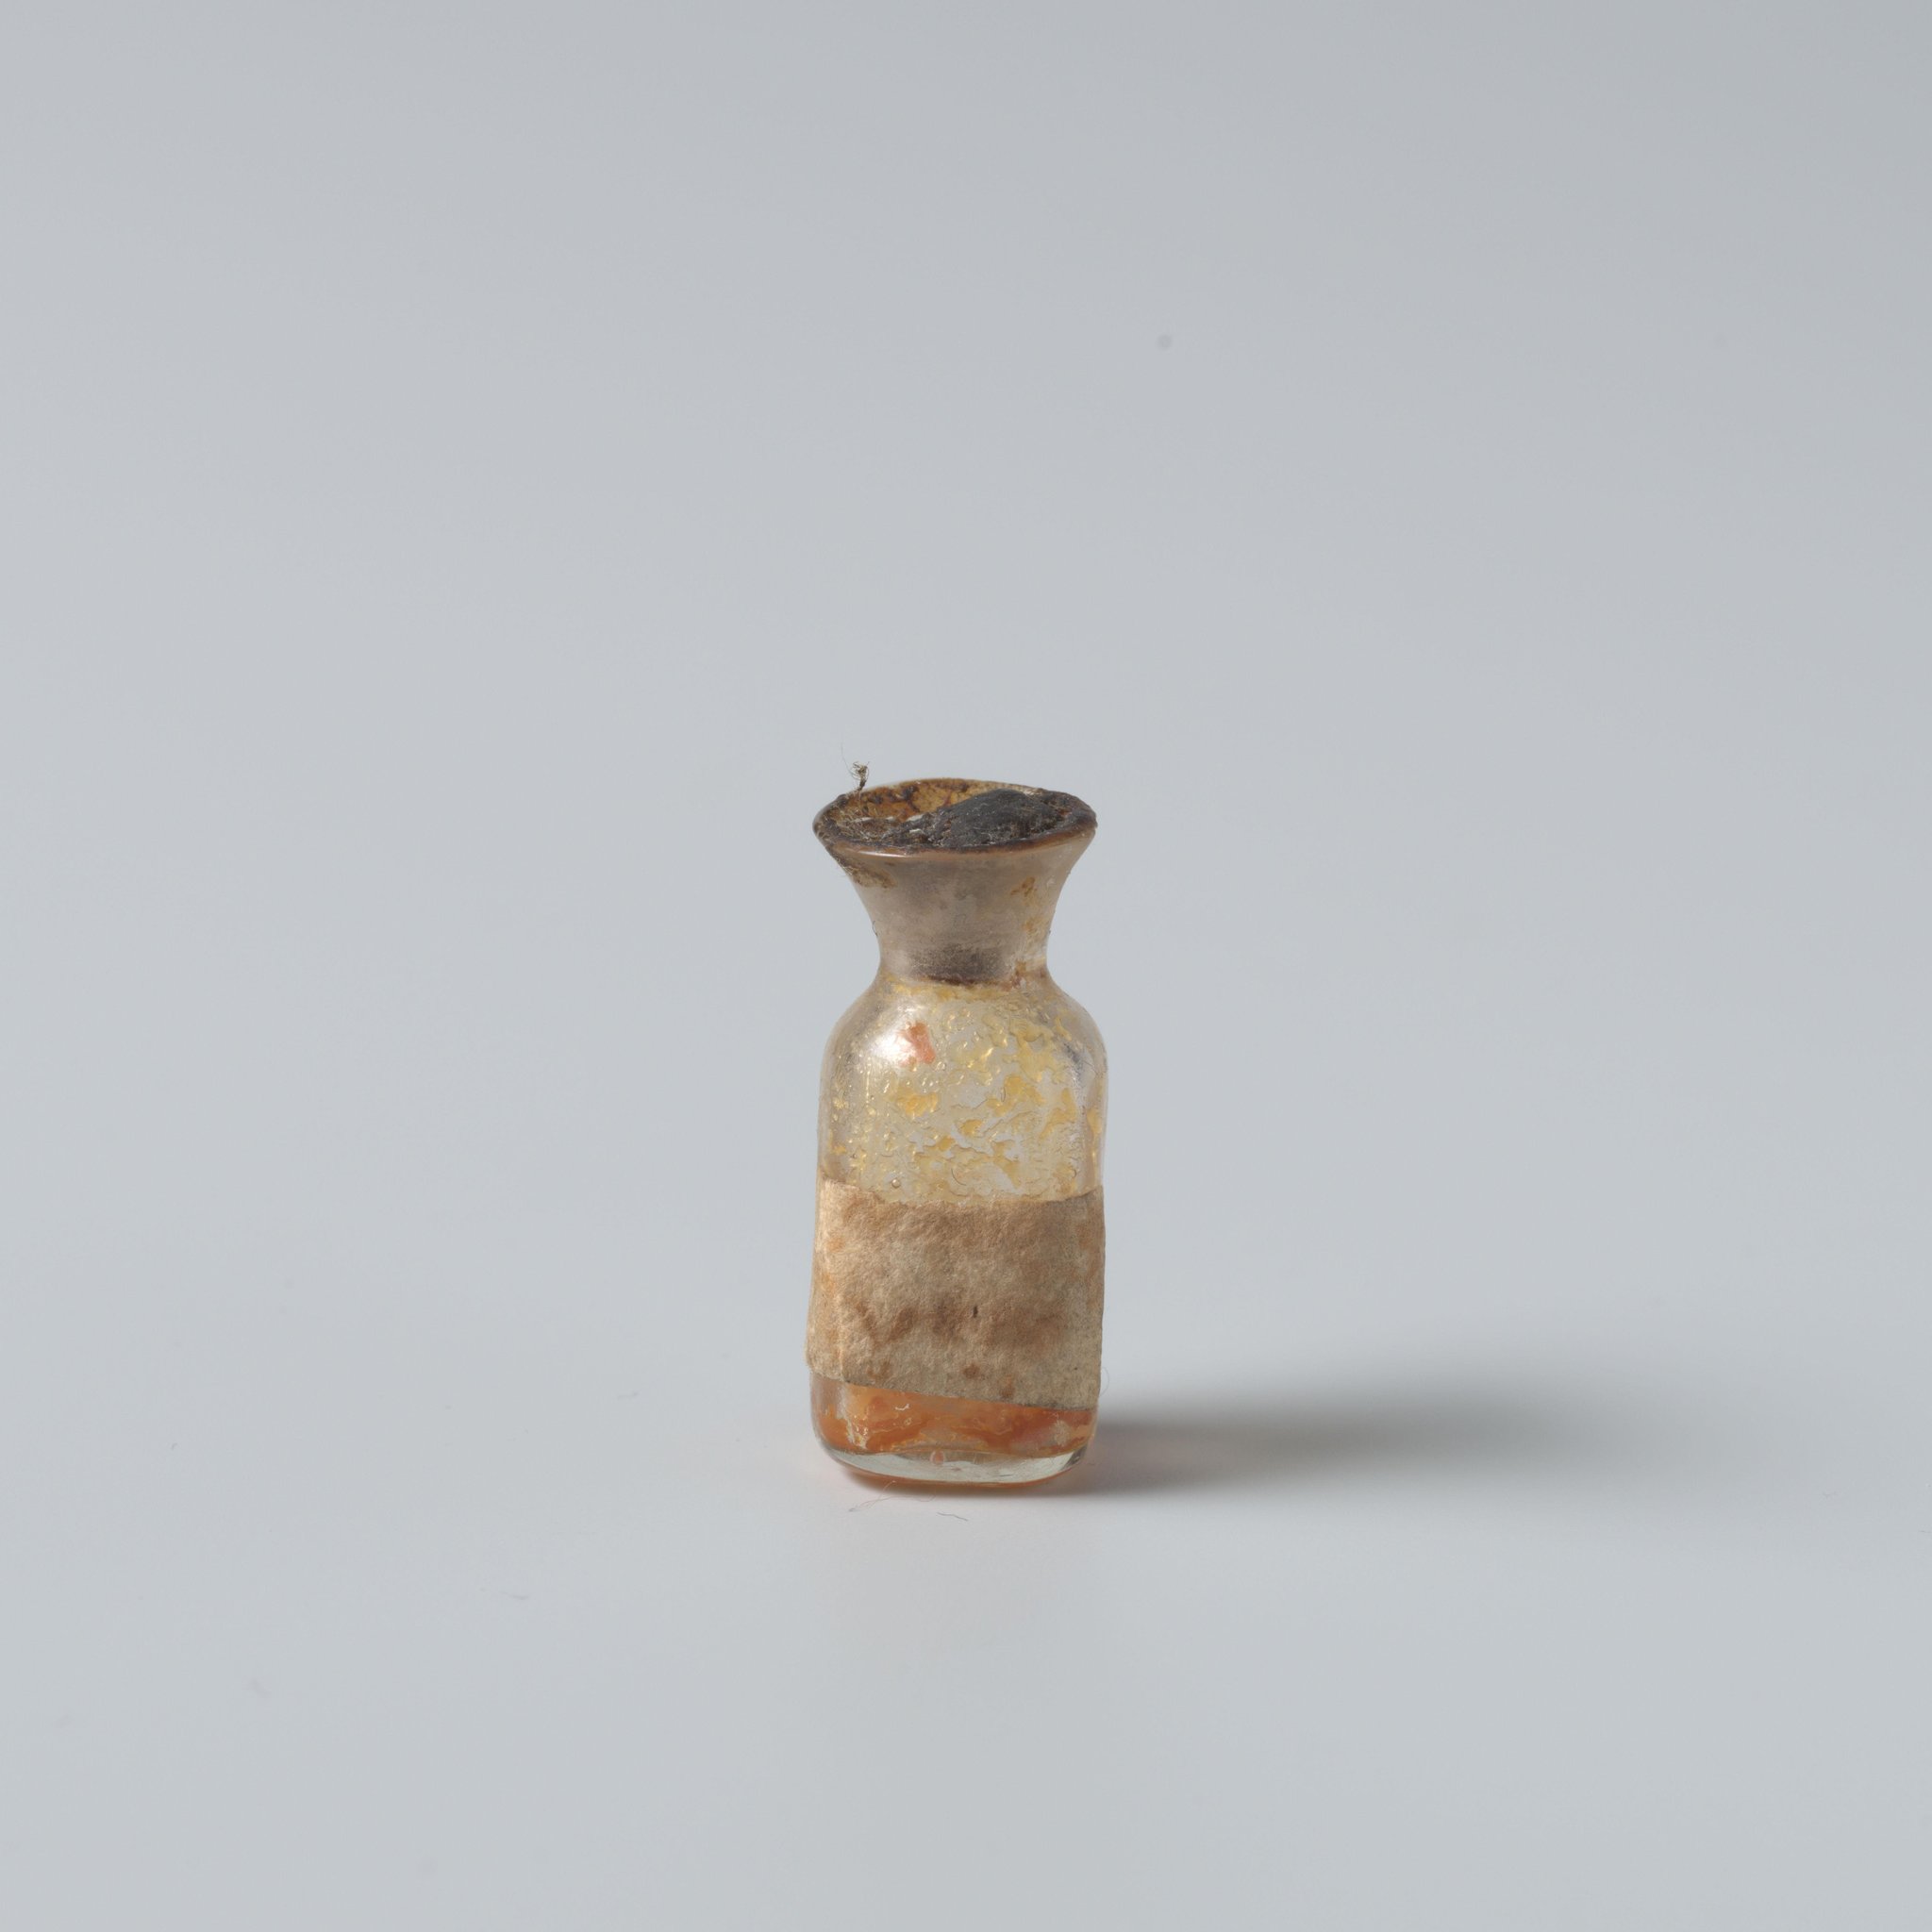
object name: miniature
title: Voorraadfles met vierkant lichaam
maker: Anonymous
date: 1700-1799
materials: glass, wax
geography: netherlands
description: Voorraadfles van helder kleurloos glas, vierkant lichaam met hals en ronde wijduitstaande mondrand. De fles draagt een etiket met een onduidelijk opschrift. In de fles resten van een vettige substantie. De fles is afgedicht met een prop was.